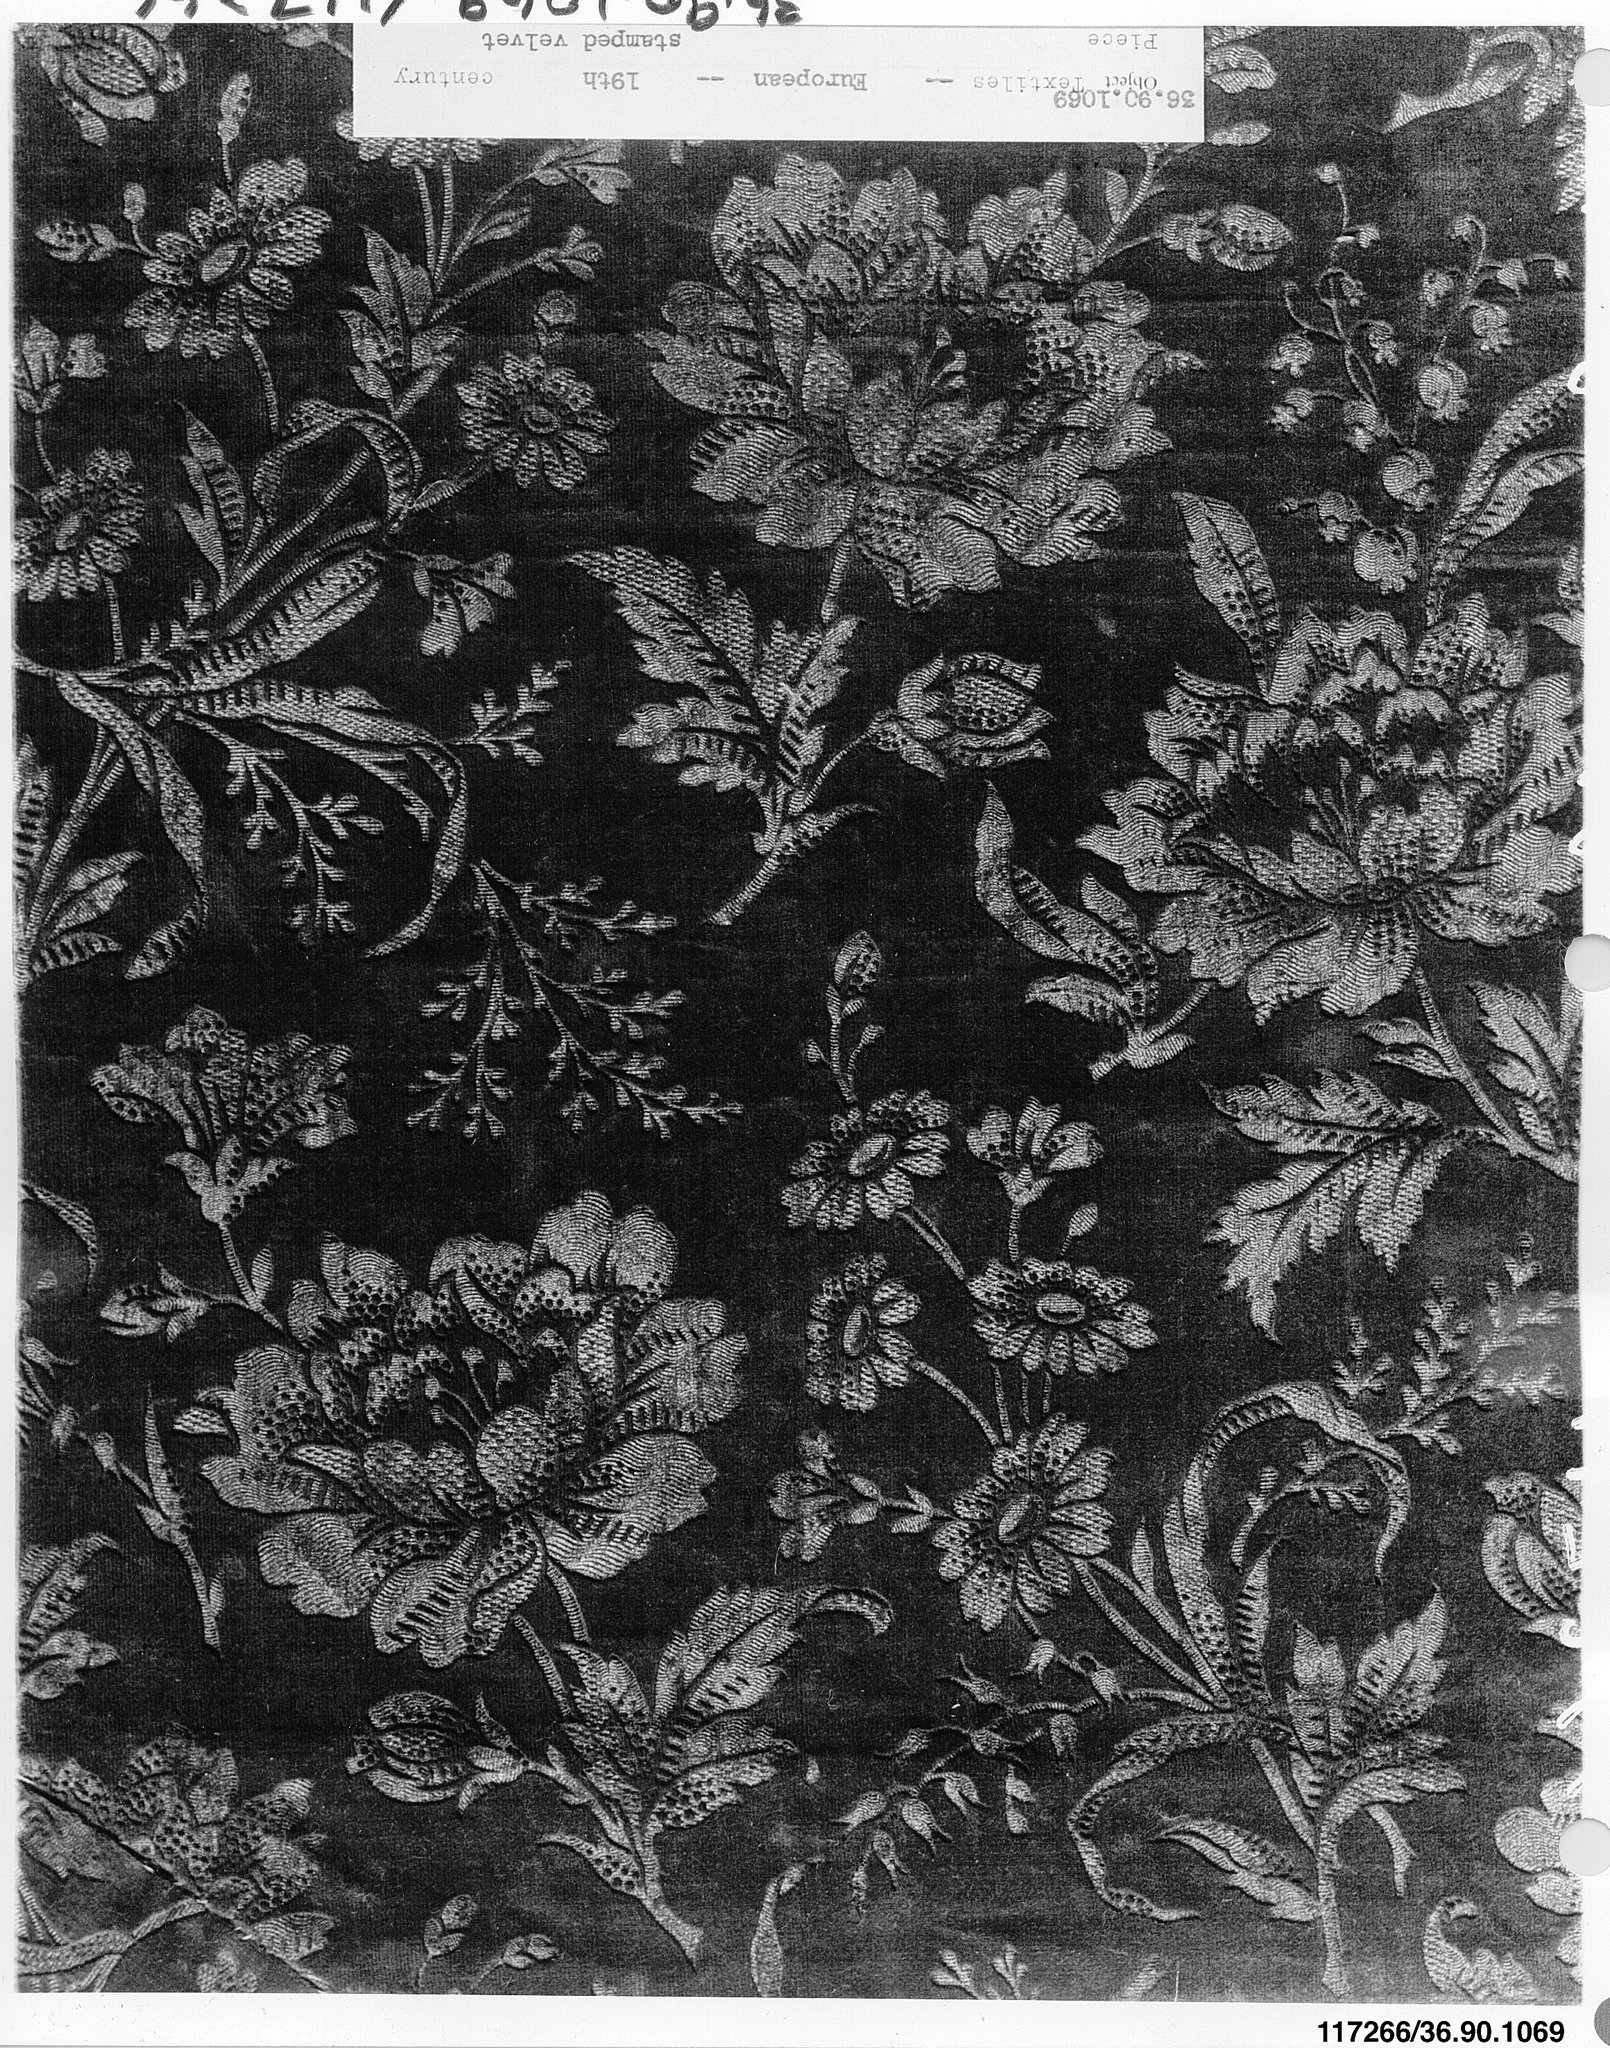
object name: piece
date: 1801-1900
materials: silk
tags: flowers,leaves